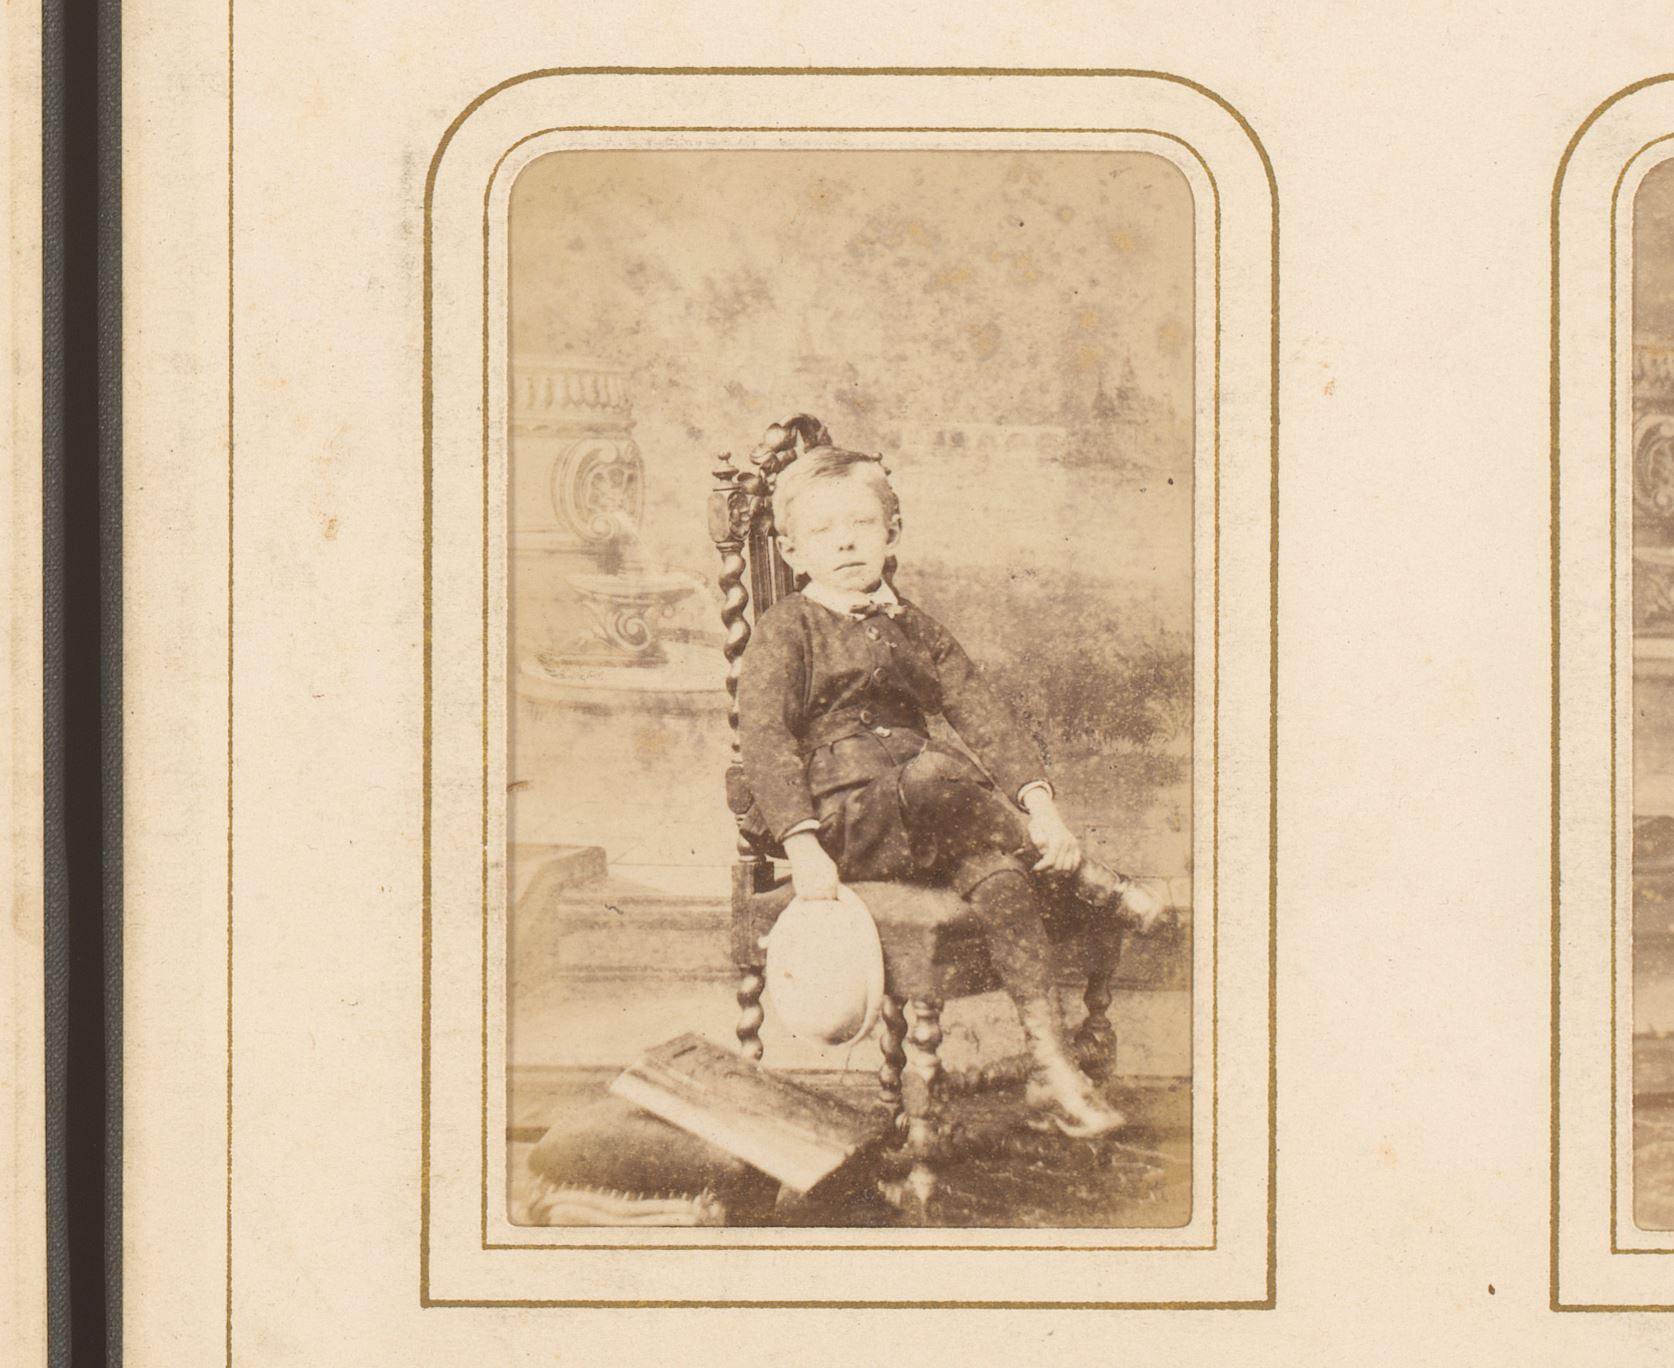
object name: carte de visite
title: Portret van een zittende jongen met hoed in de hand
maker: eugene guérin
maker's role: fotograaf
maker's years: 1845-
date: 1875-1885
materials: cardboard, photographic support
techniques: albumen print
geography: brussels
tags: sitting figure, boy (child between toddler and youth), historical persons, head-gear: hat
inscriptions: inscription: ‘E Guérin/ BRUXELLES./ 32 Rue de Louvain.’